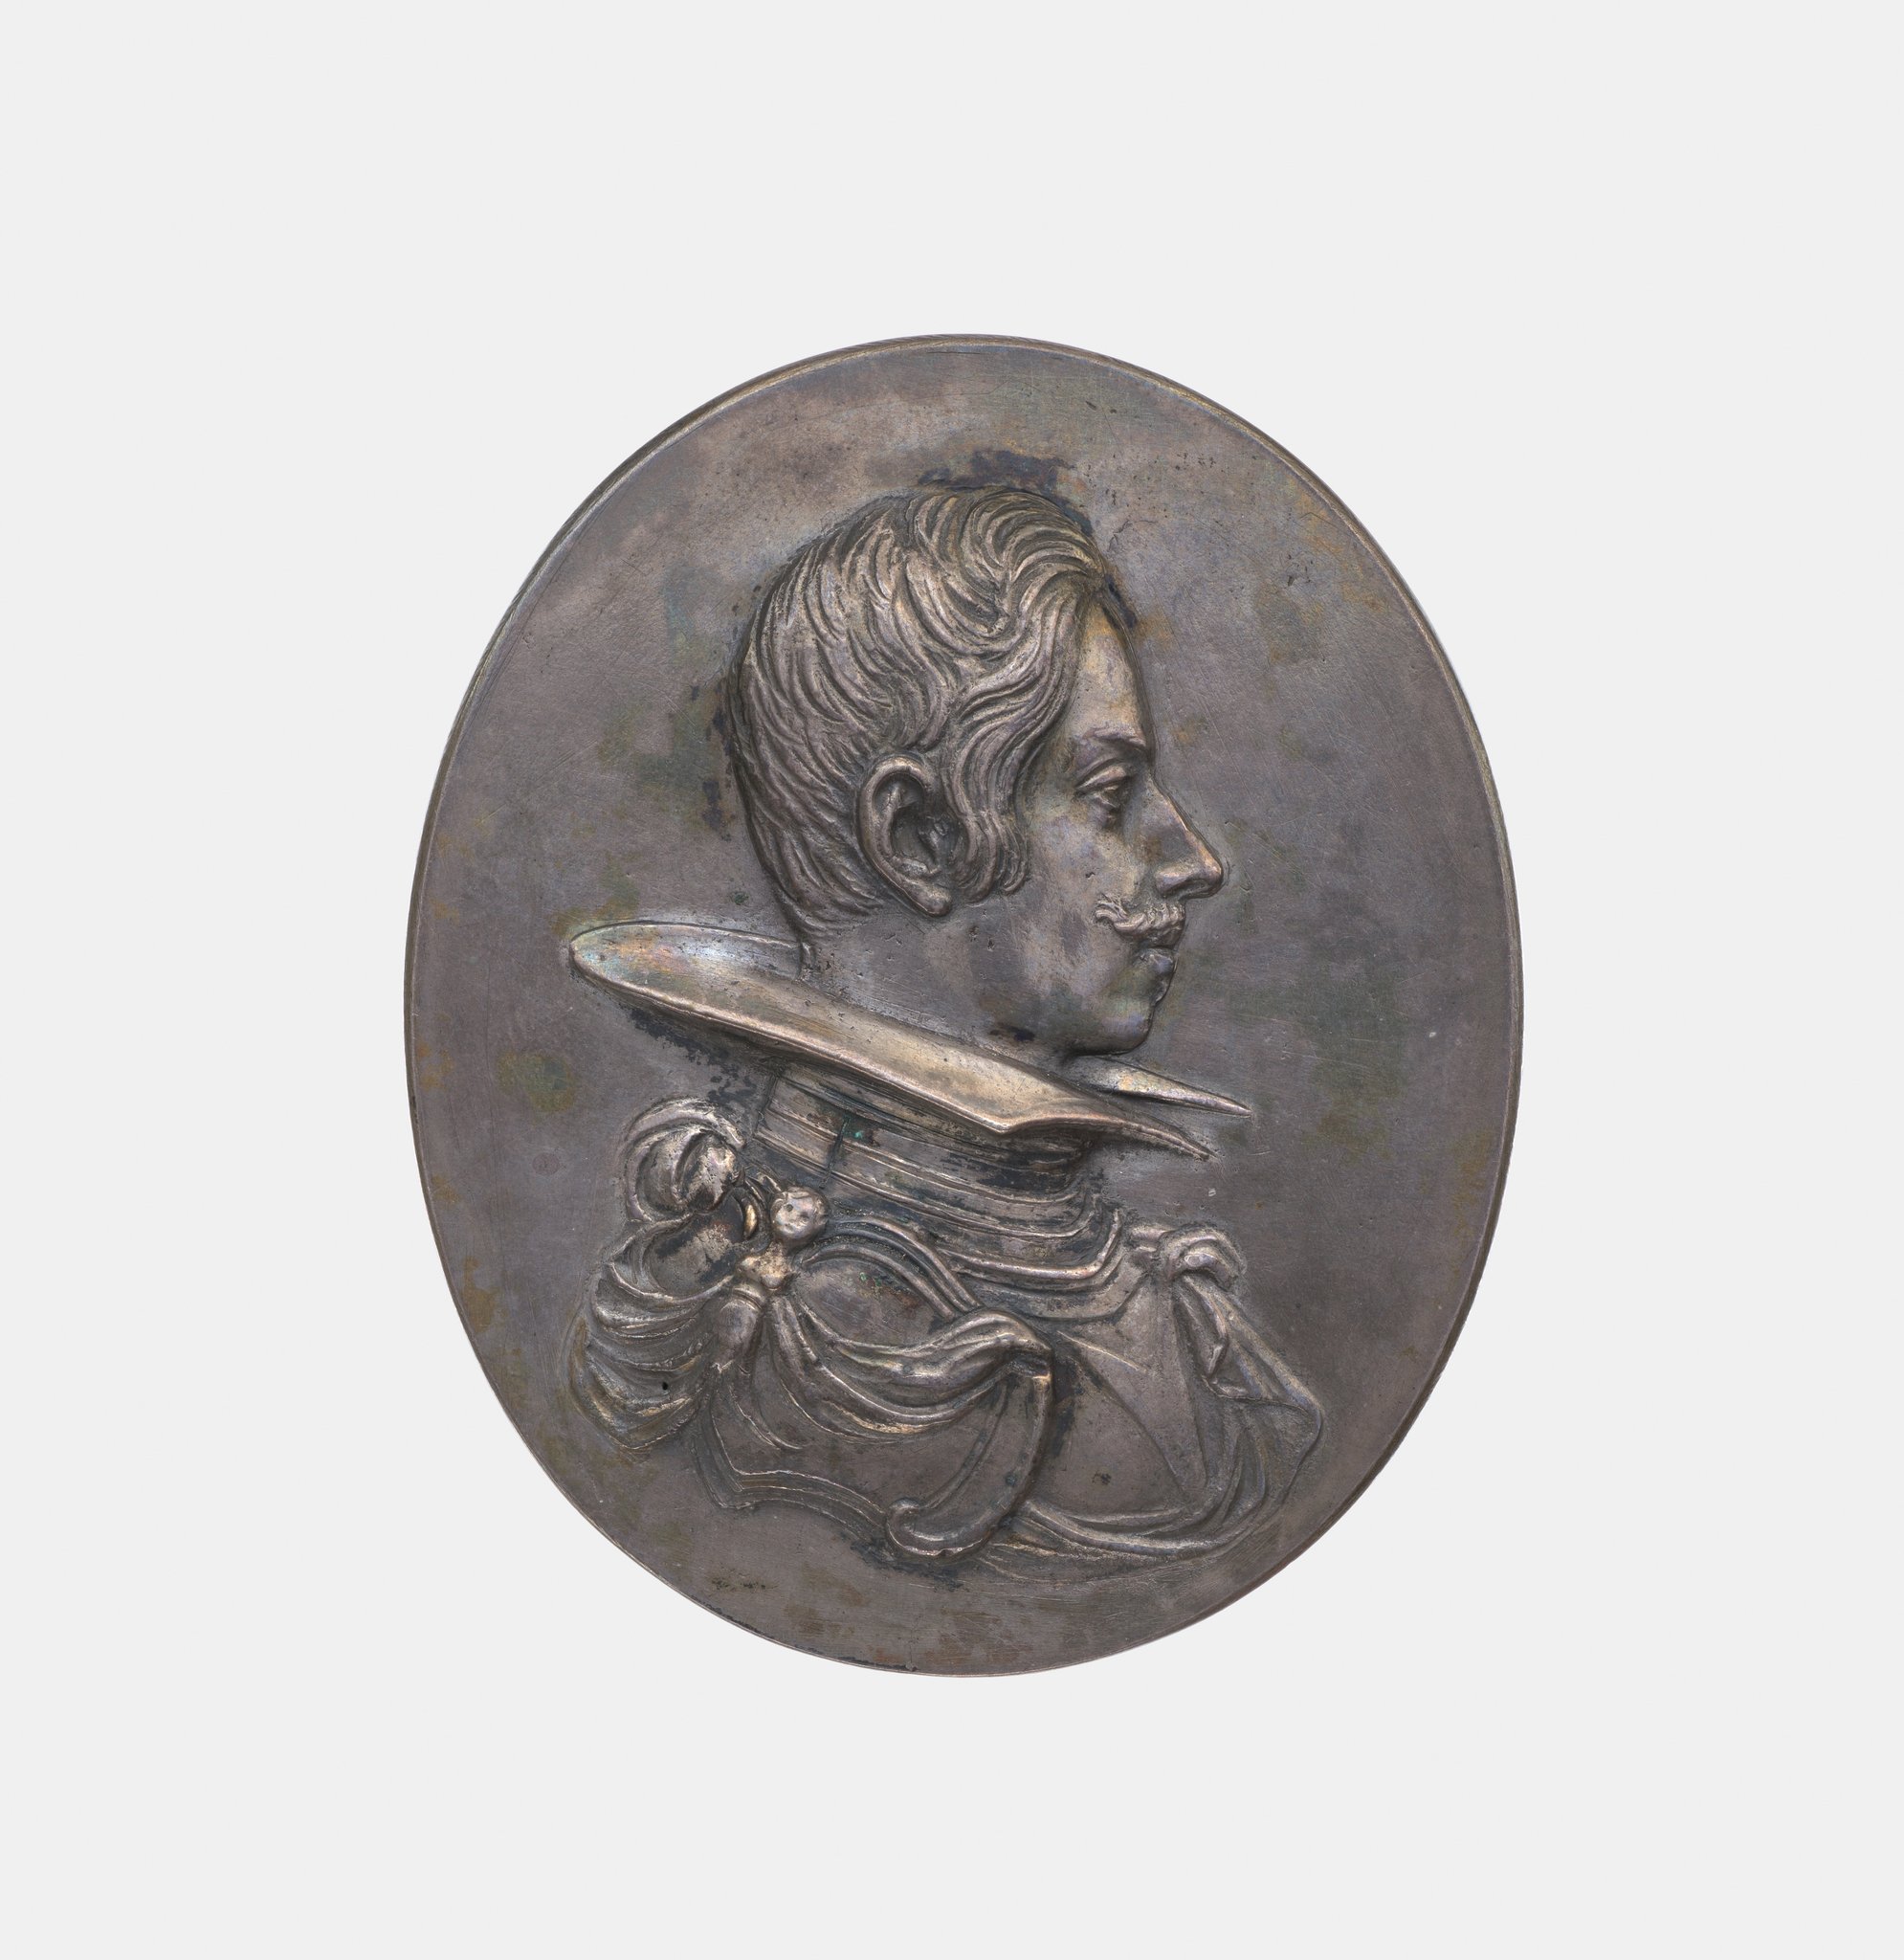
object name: medal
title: Cosimo II de' Medici 1590-1620, Grand Duke of Tuscany 1608-20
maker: gasparo mola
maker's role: artist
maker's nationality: italian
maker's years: 1575-1640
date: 1590-1640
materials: silver